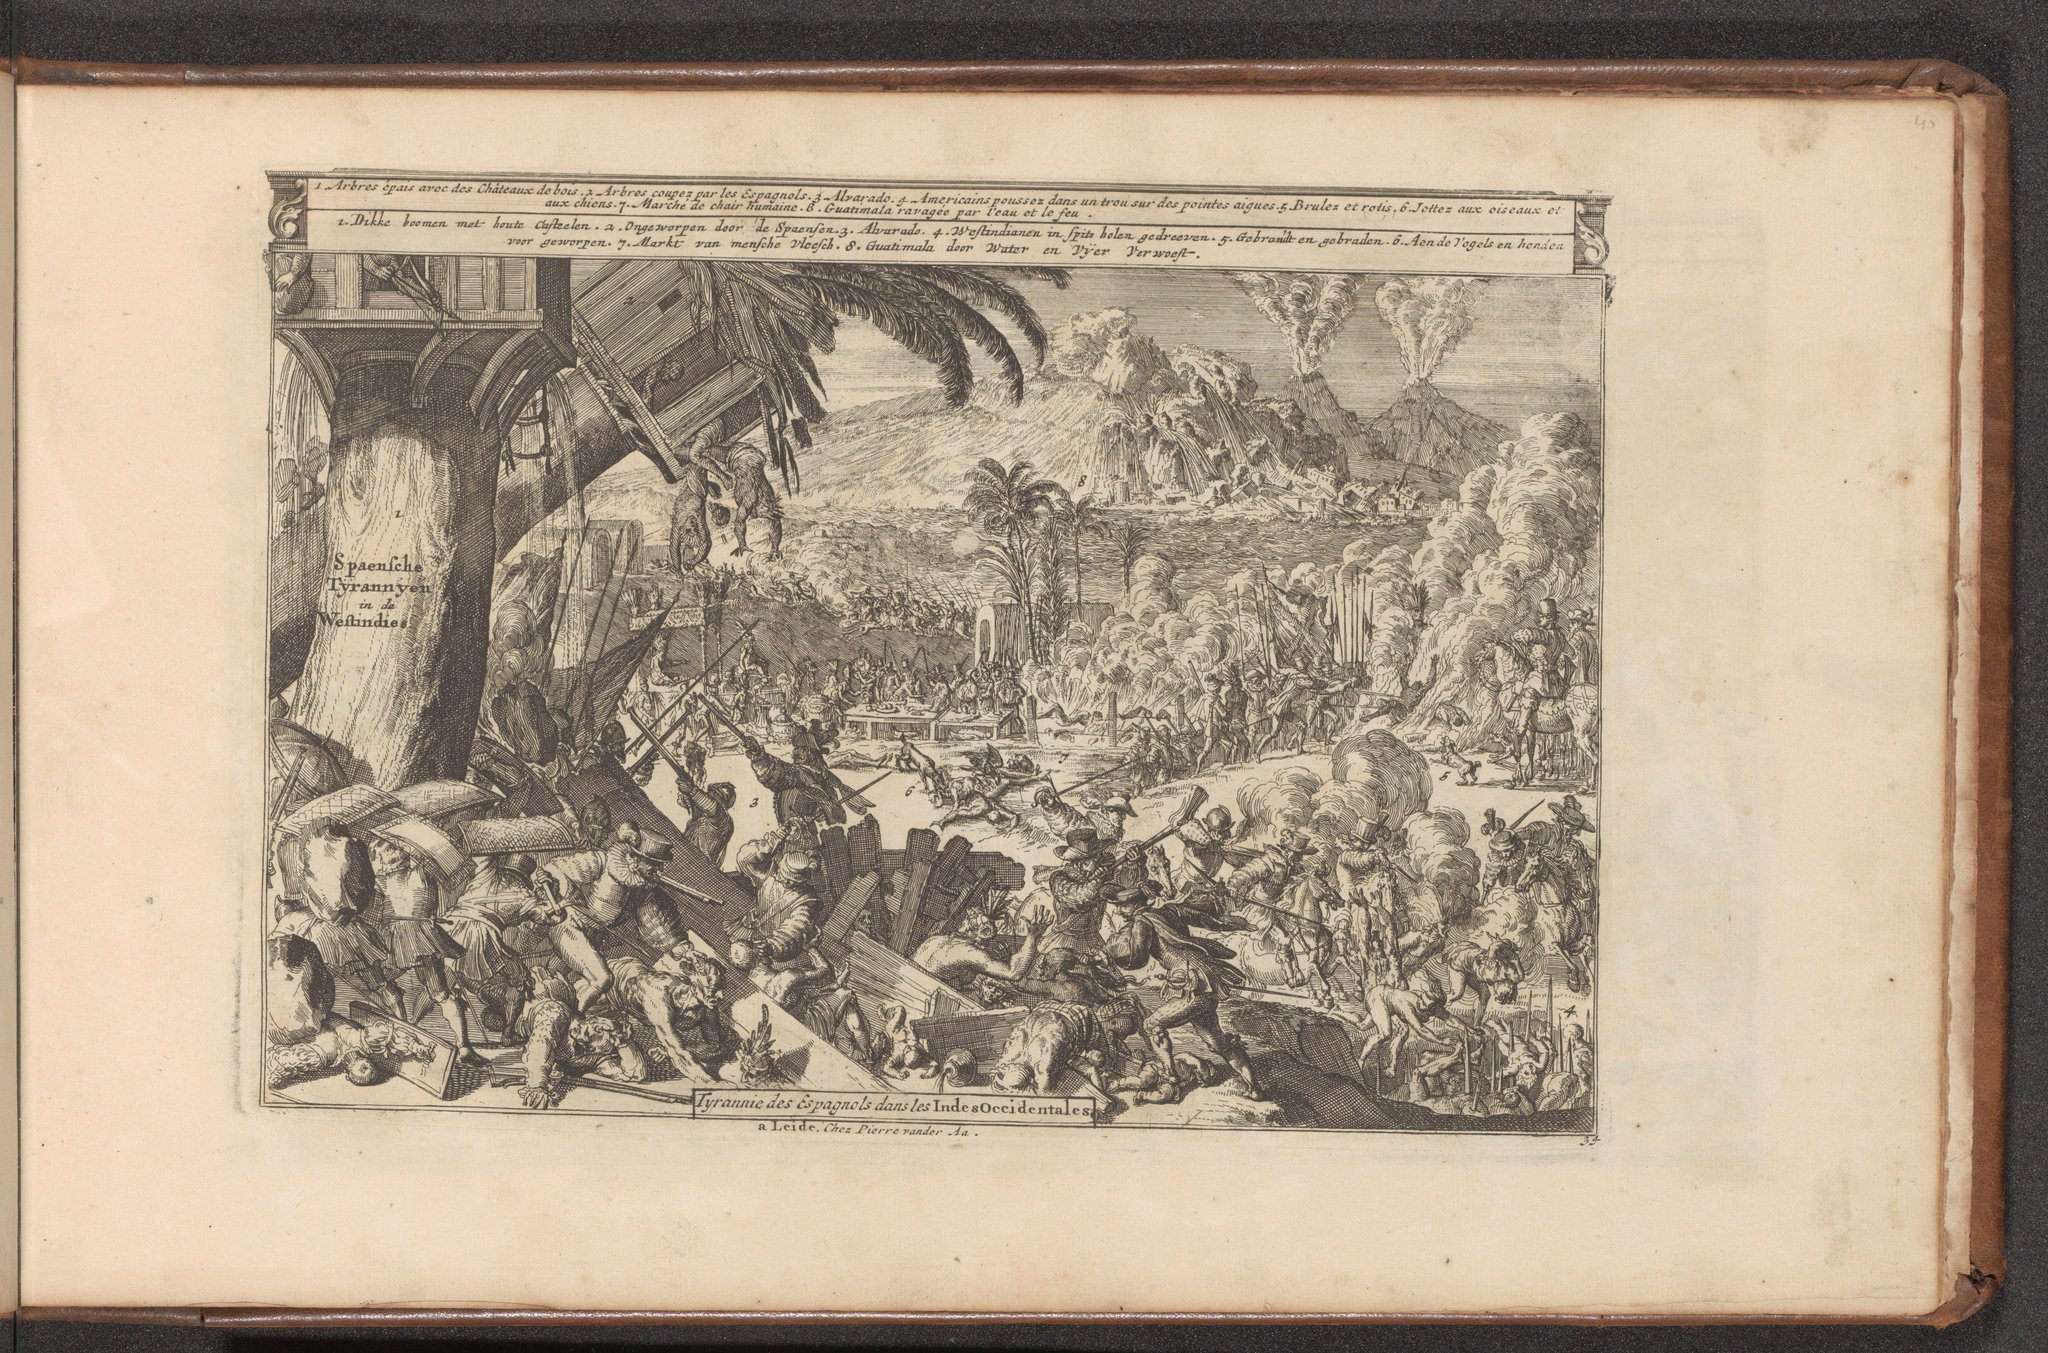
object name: album leaf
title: Spaensche Tyrannyen in de Westindies / Tyrannie des Espagnols dans les Indes Occidentales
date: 1682-1733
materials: paper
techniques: etching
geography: leiden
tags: violent death, being killed; being mishandled and maltreated; seeking death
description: Spaanse wreedheden in West-Indië. Links wordt een boom met een houten huis omgeworpen door de Spanjaarden. Talloze lokale inwoners worden afgeslacht. Ze worden onder meer in een kuil gedreven met spitse staken. Tussen de wreedheden staat Pedro de Alvarado, een Spaanse conquistador. Achter hem worden enkele mensen door vogels en honden opgegeten. Guatemala wordt door water en vuur verwoest. Met een legenda in het Nederlands en het Frans. De prent maakt deel uit van een album.